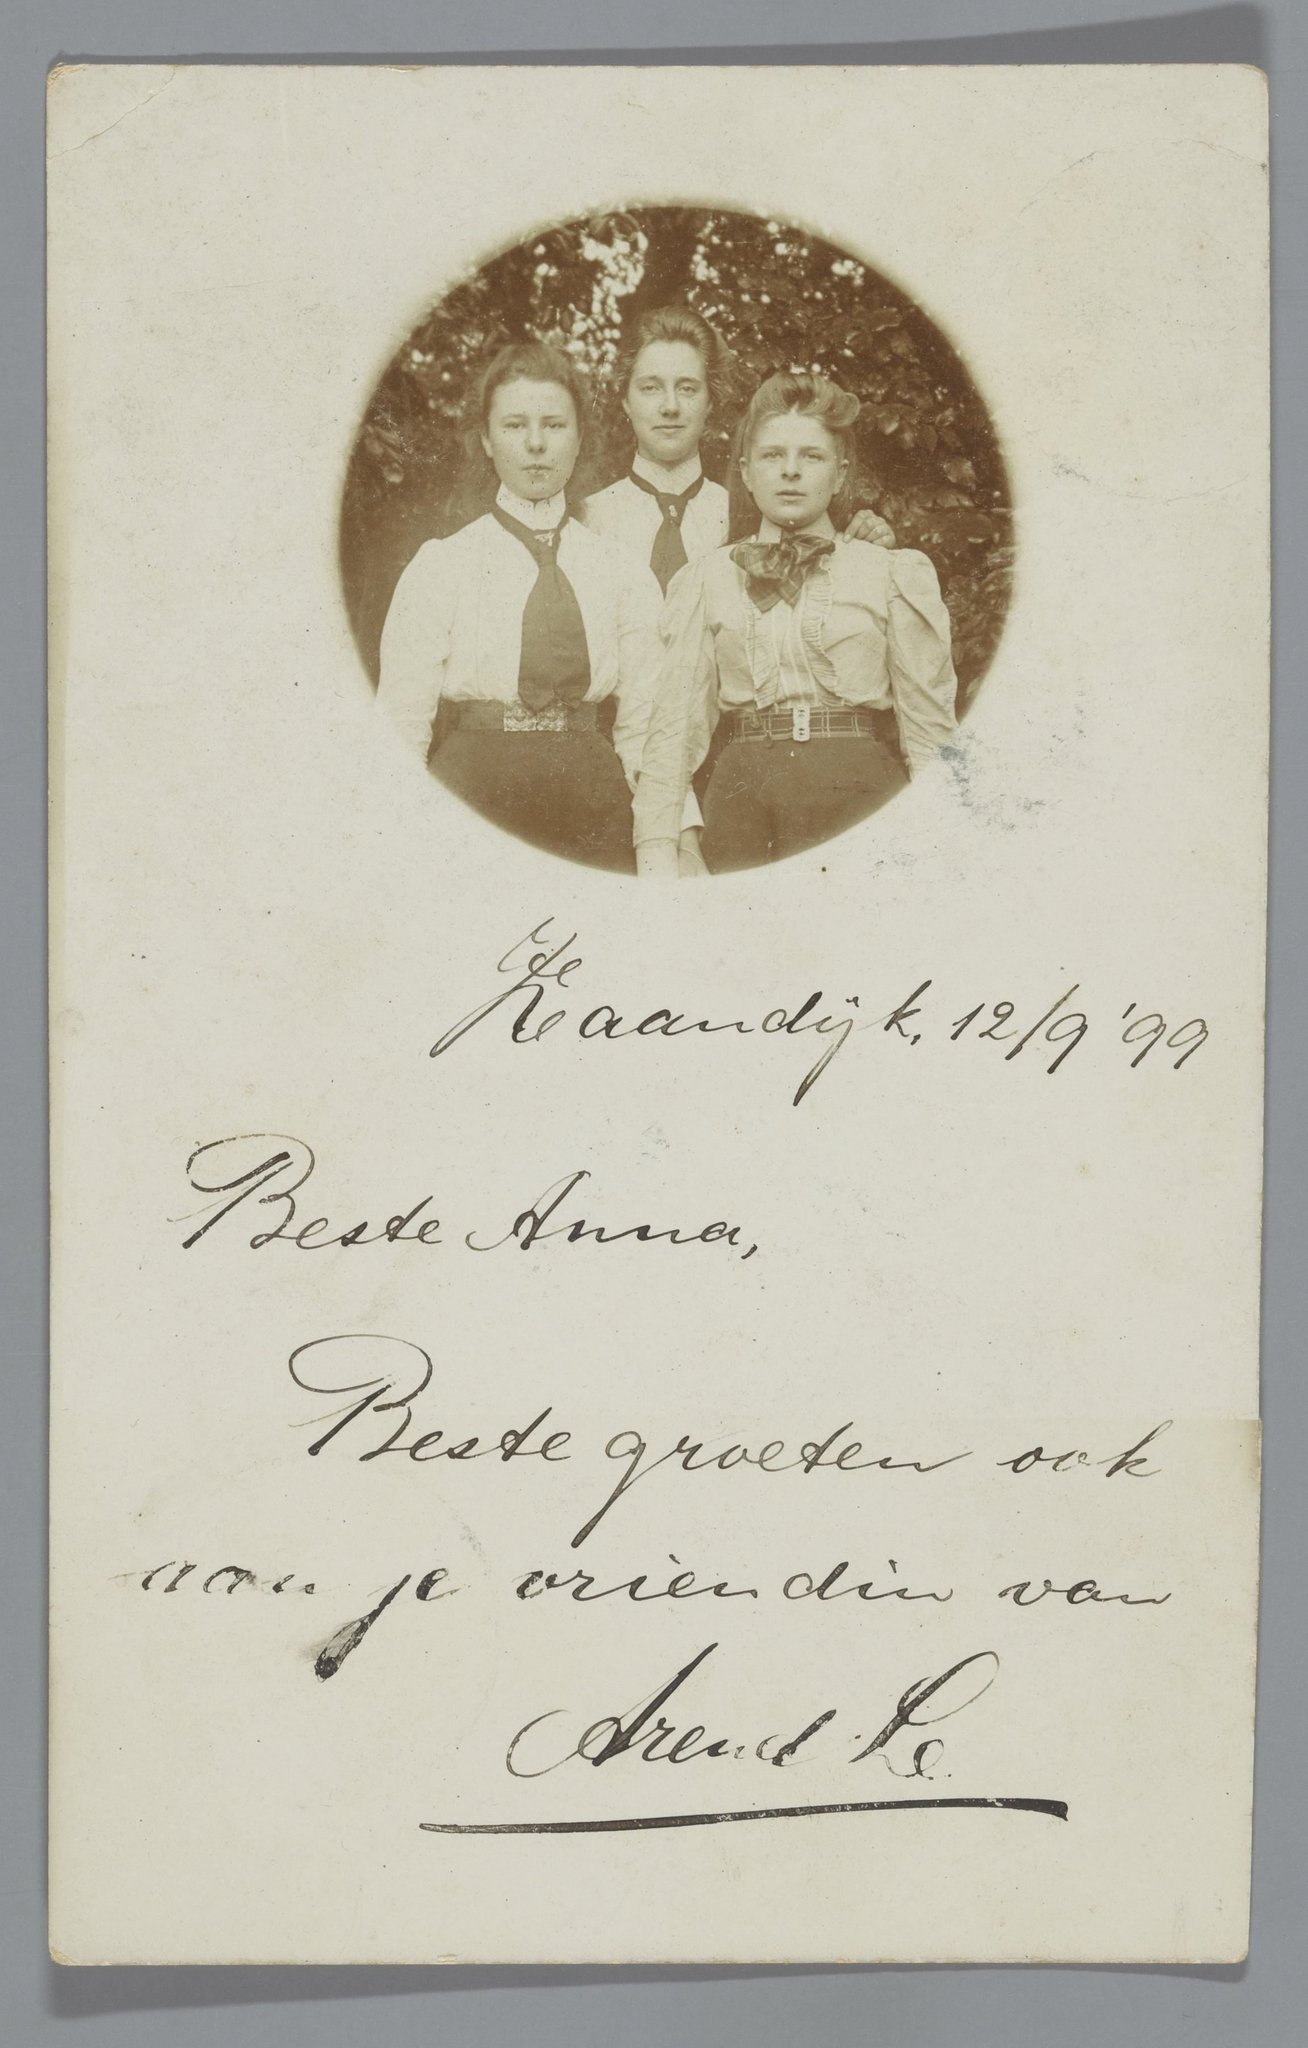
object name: photograph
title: Portret van drie onbekende vrouwen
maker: Anonymous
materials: photographic support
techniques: daylight paper print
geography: netherlands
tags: adolescent, young woman, maiden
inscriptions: inscription: ‘Mej Anna Honig p/a Kweekschool voor Onderwijzeressen Haarlem.’, inscription: ‘Zaandijk, 12/9 '99 (...) Arend Le’